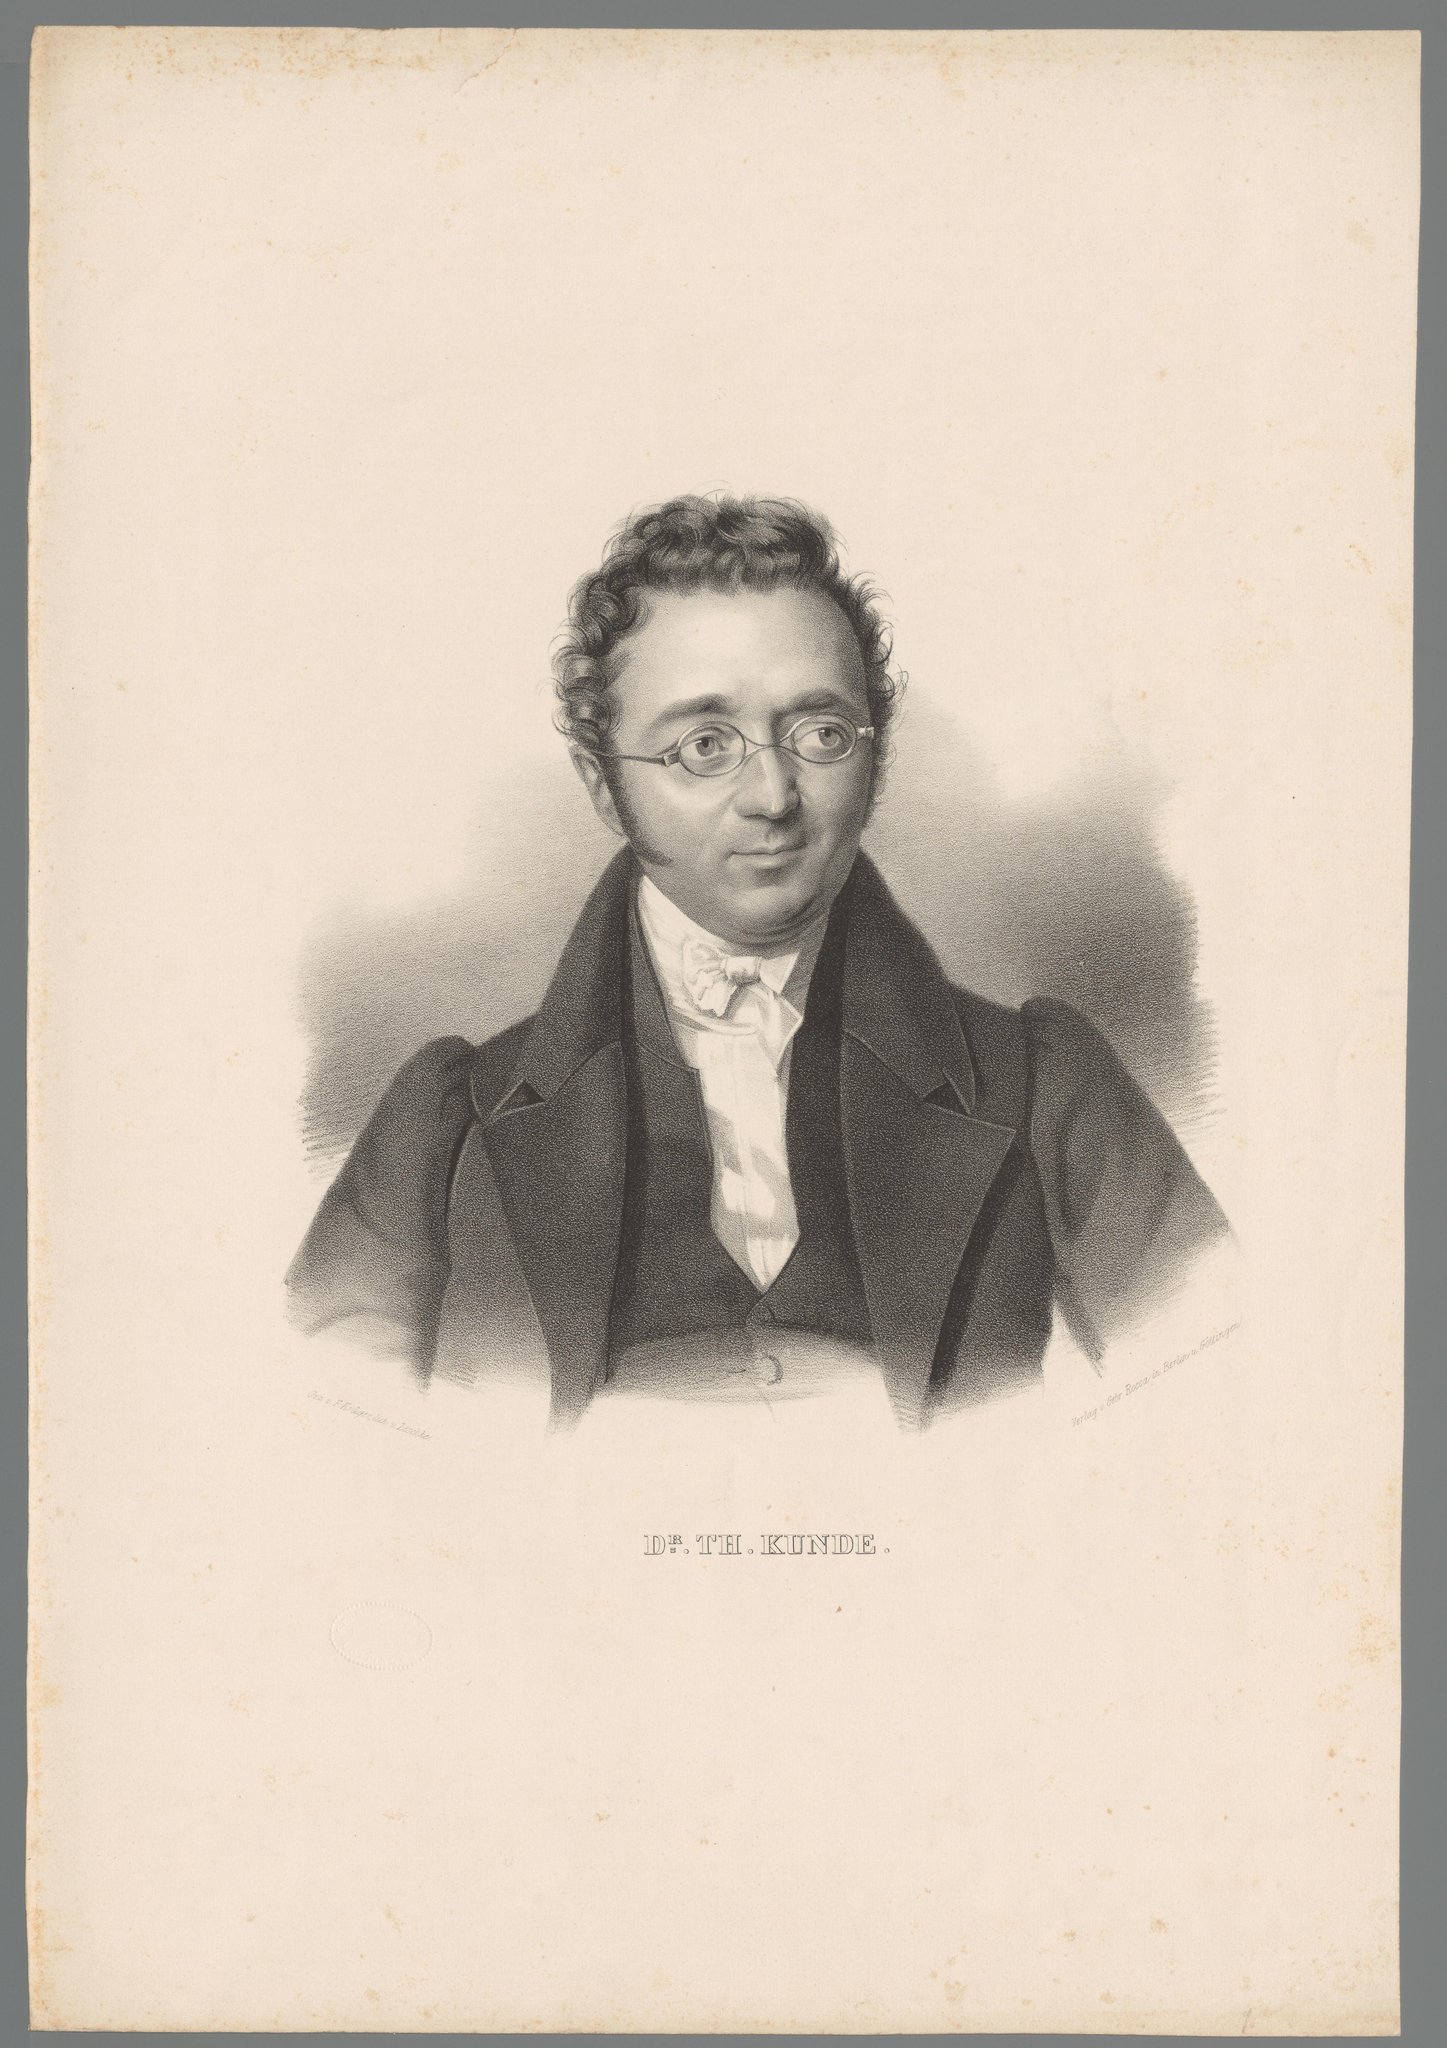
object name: print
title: Portret van Th. Kunde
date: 1815-1874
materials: paper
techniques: lithograph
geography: gottingen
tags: historical persons not known by name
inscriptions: collector's mark: Lugt 2228, check stamp: Lugt 5514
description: Portret van een verder onbekende man met de naam Th. Kunde.